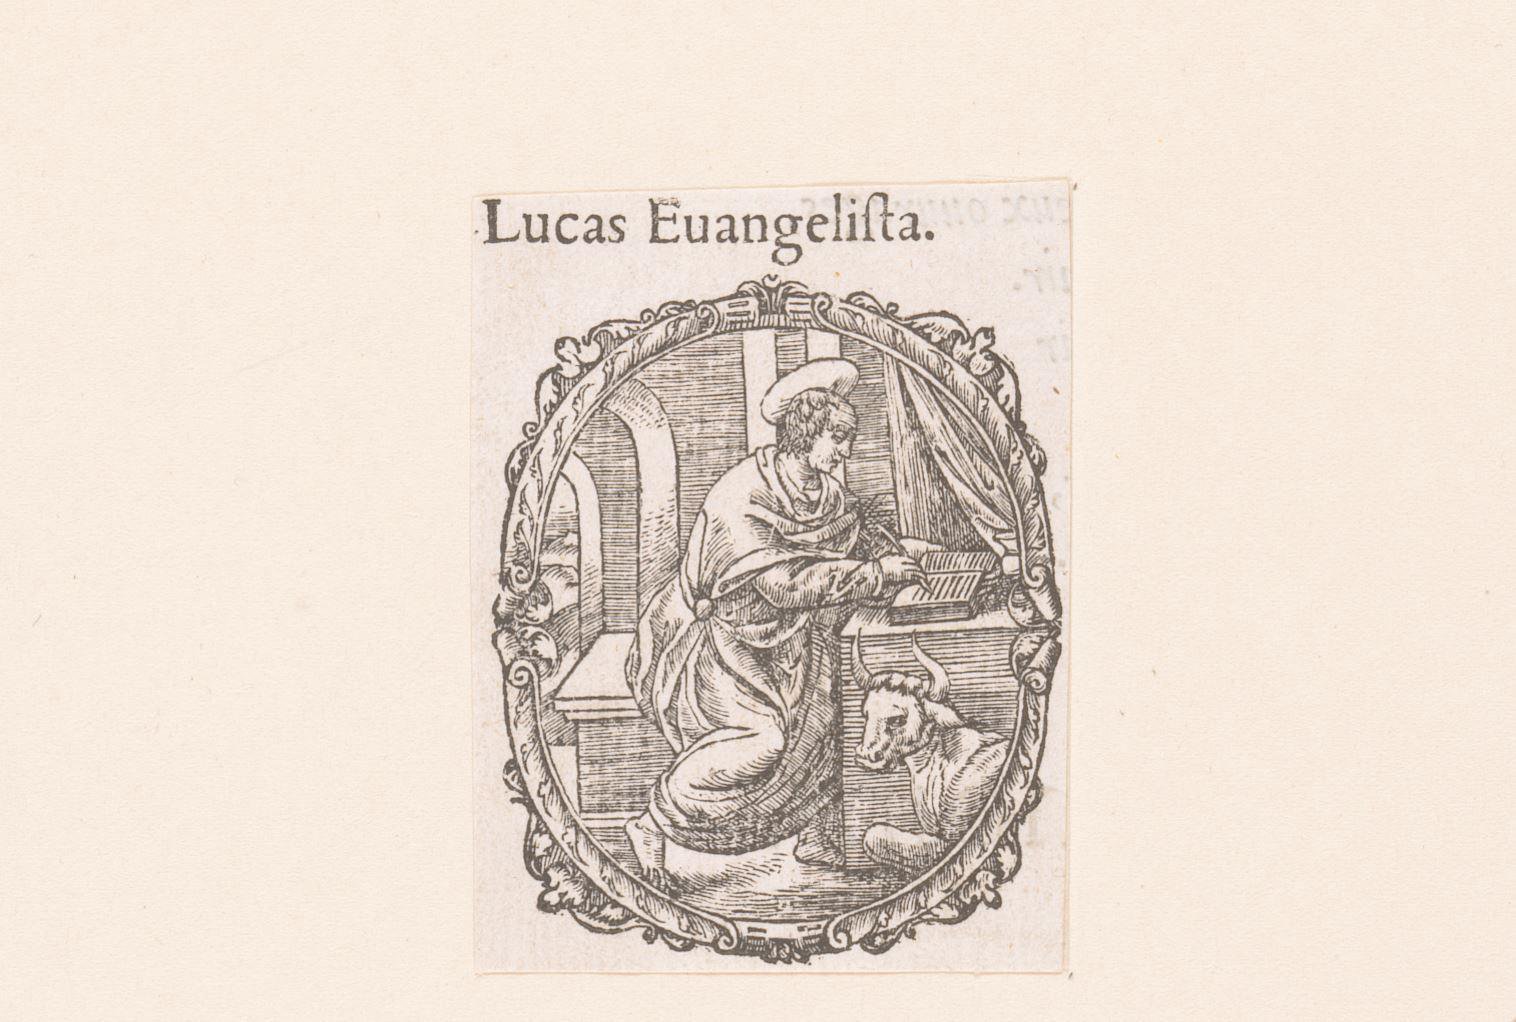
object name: print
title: Evangelist Lucas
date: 1547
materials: paper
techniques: woodcut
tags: luke the evangelist; possible attributes: book, (winged) ox, portrait of the virgin, surgical instruments, painter's utensils, scroll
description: Prent afkomstig uit: Icones Historiarum Veteris Testamenti. Lyon: Johannes Frellon, 1547.